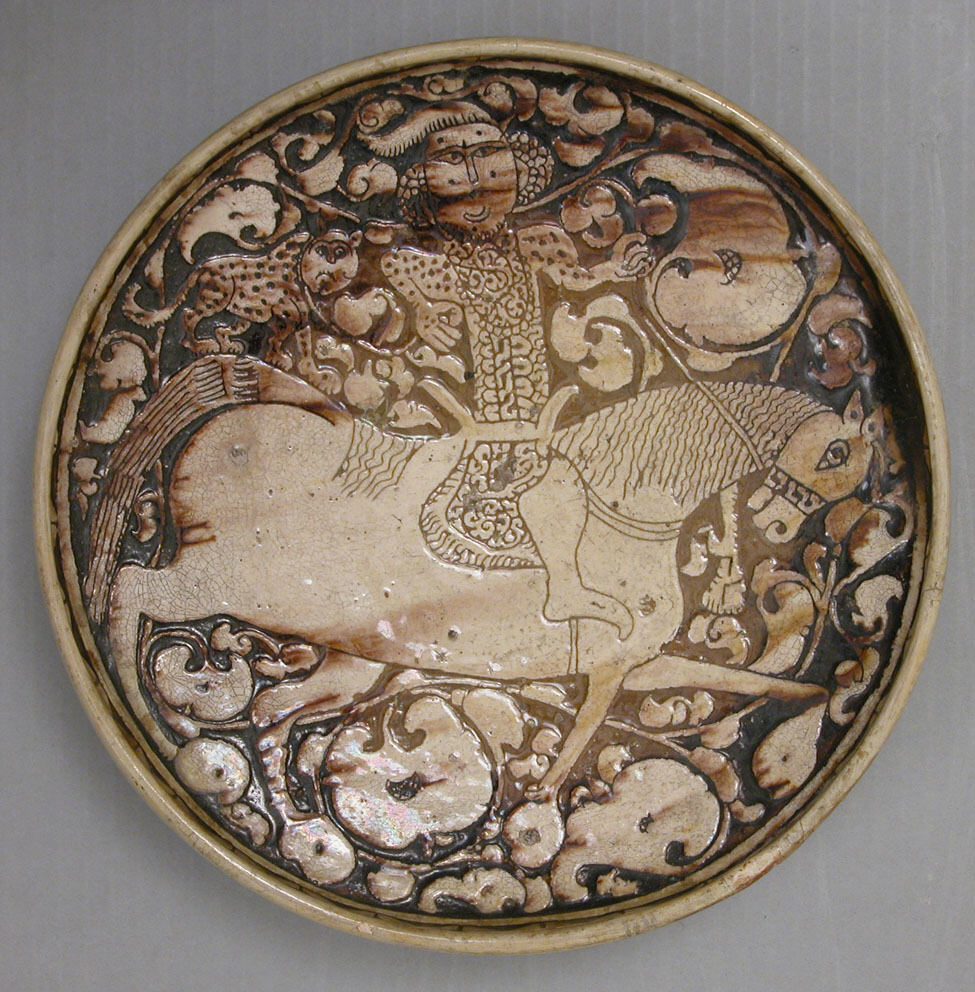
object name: dish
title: Dish with a Horseman and Trained Cheetah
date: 1901-2000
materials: earthenware, glaze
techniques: carving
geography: iran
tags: men,cheetahs,horses